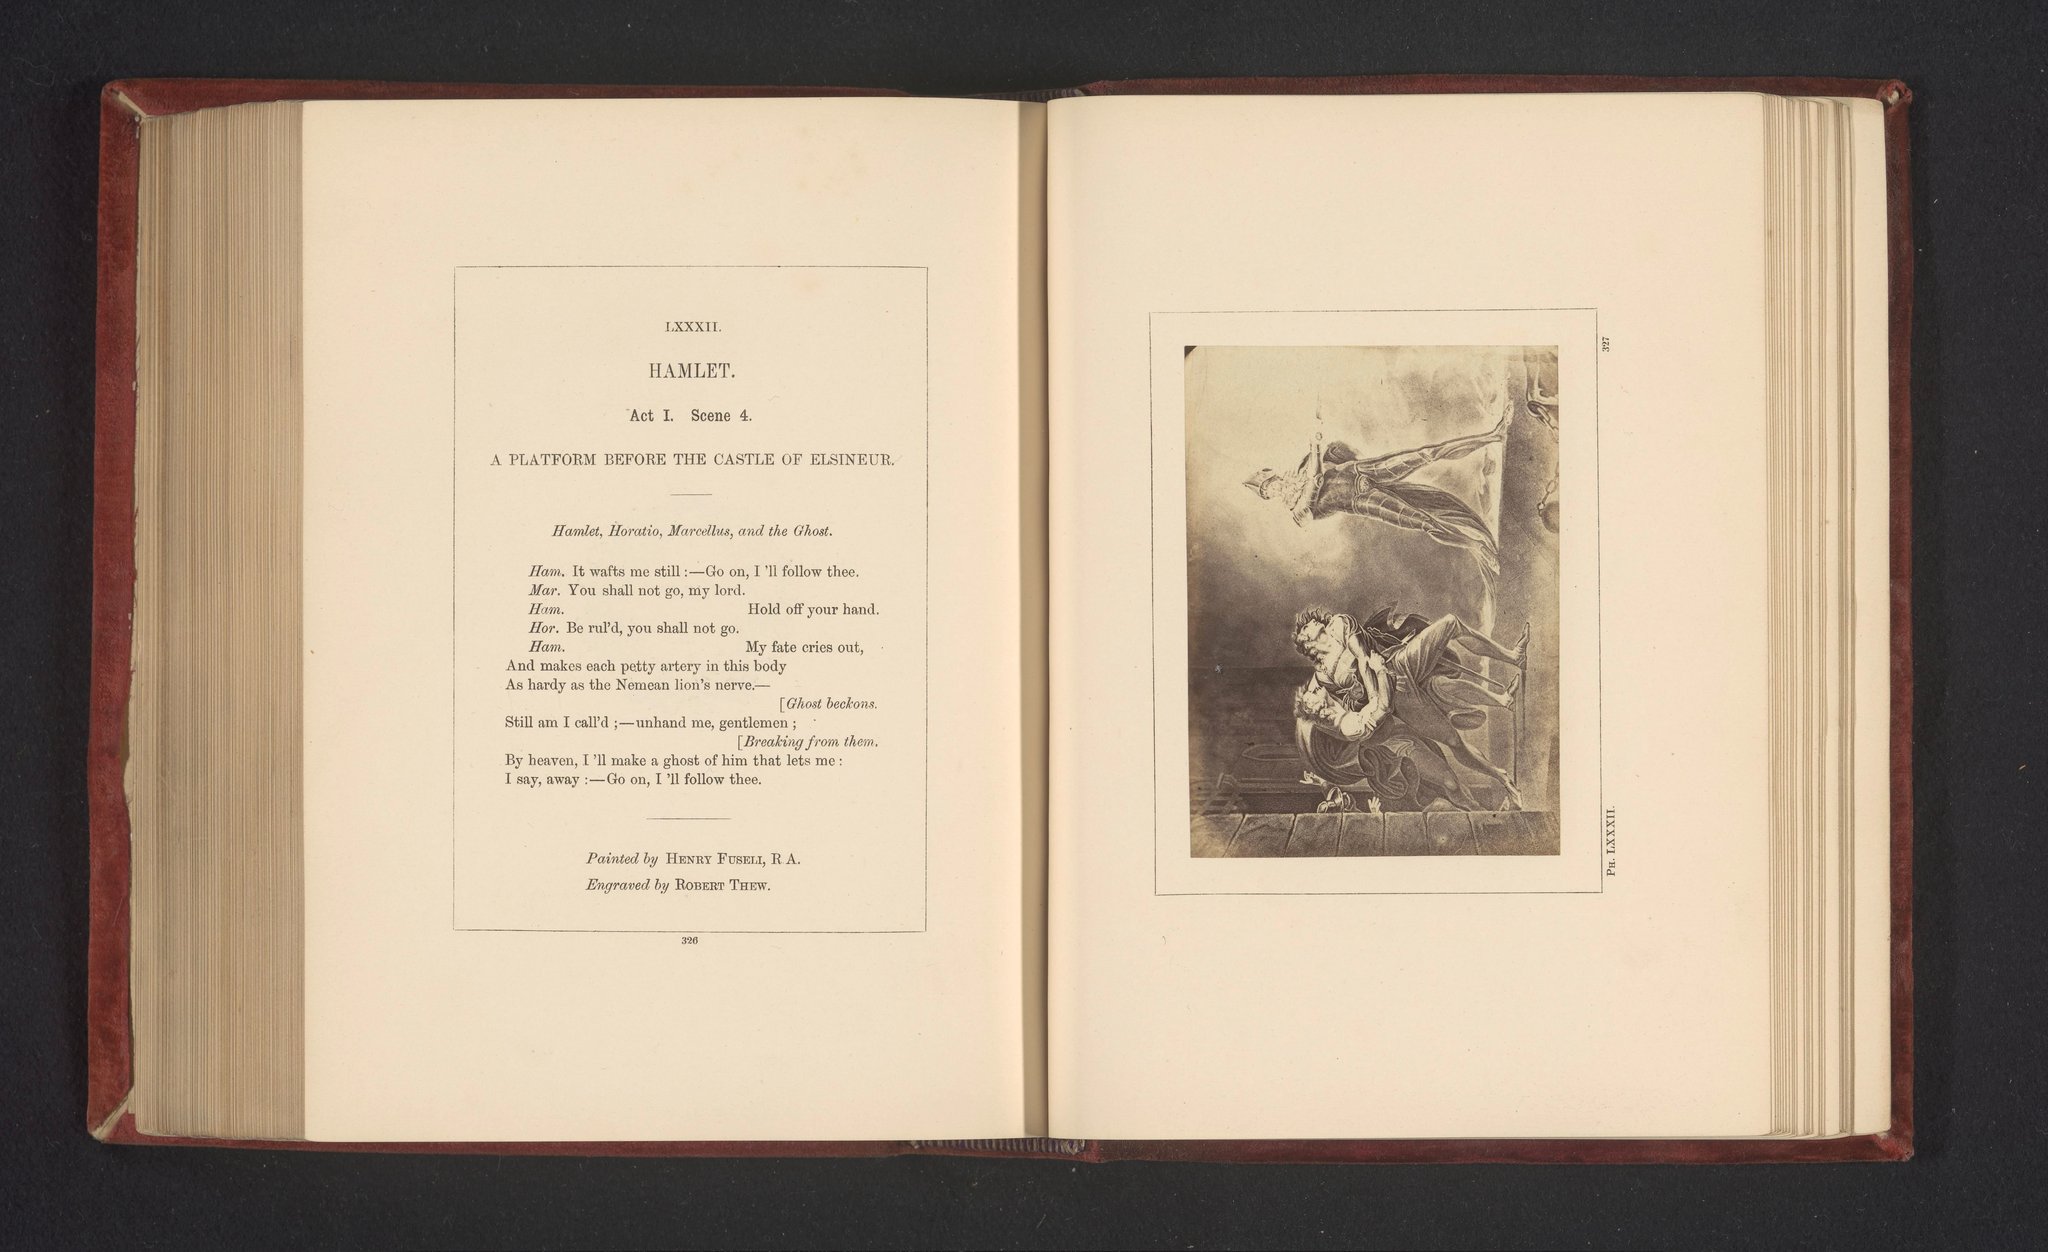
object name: page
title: Fotoreproductie van een prent naar een schilderij door Johann Heinrich Füssli, voorstellend een scene uit Hamlet door William Shakespeare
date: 1854-1864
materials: photographic support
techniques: albumen print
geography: london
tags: hamlet, prince of denmark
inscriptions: number: ‘Ph. LXXXII. 327’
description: Te zien is akte I, scene 4 met Hamlet en Horatio voor het kasteel met de Geest.